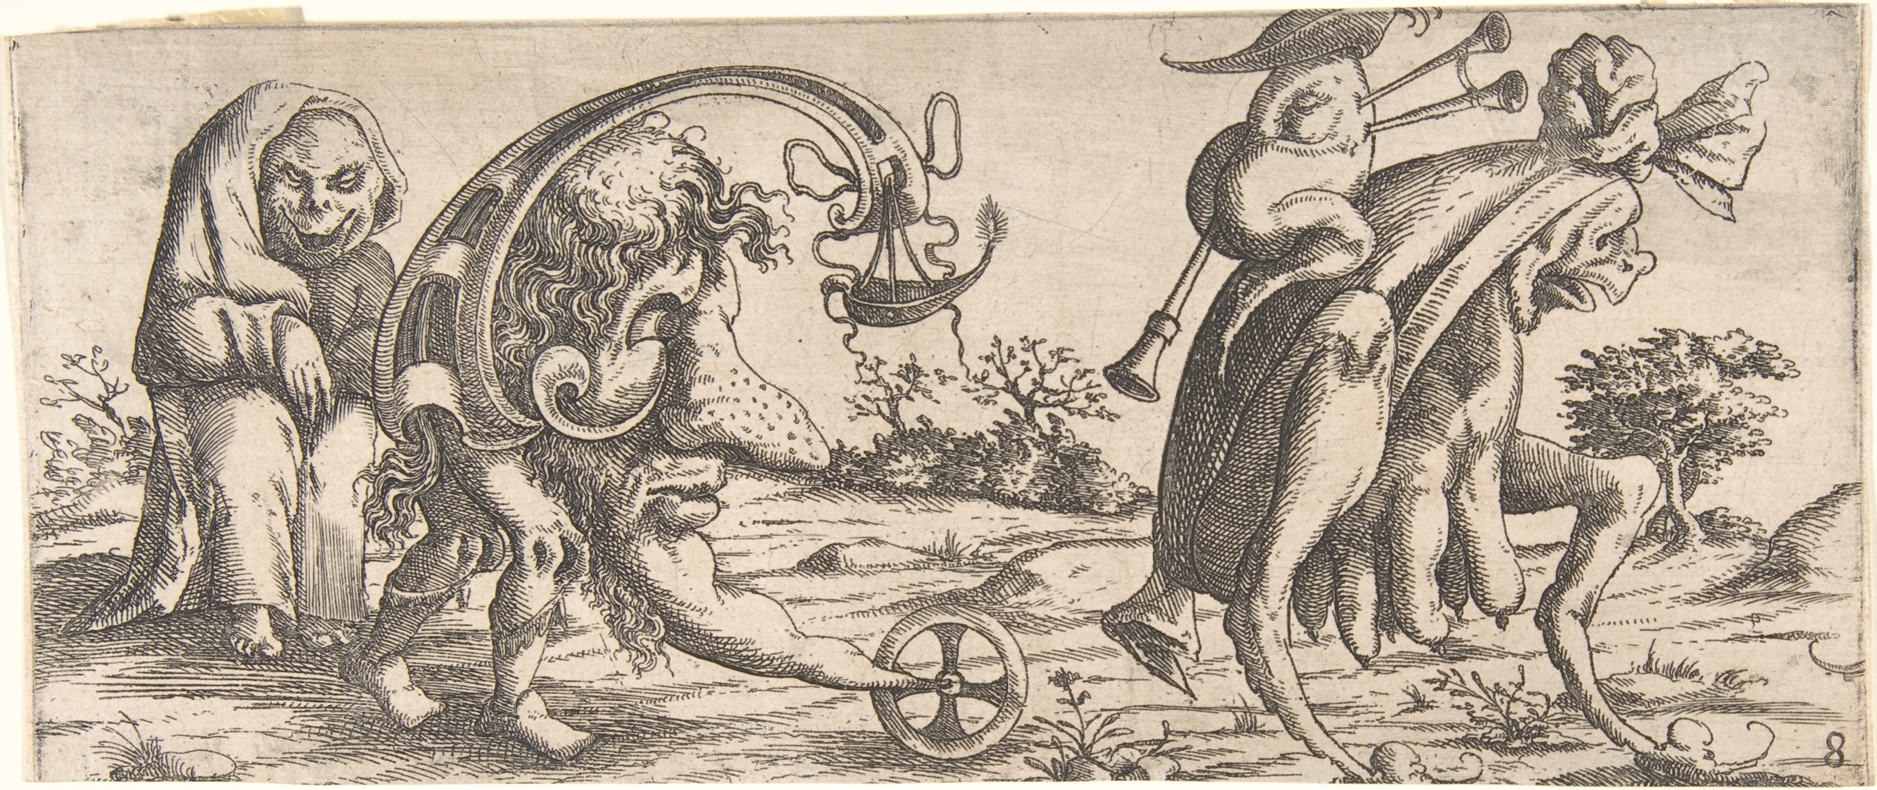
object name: print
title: Procession of Monstrous Figures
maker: wendel dietterlin, the younger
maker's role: artist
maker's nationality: german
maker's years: 1614-1669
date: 1615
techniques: etching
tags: monsters